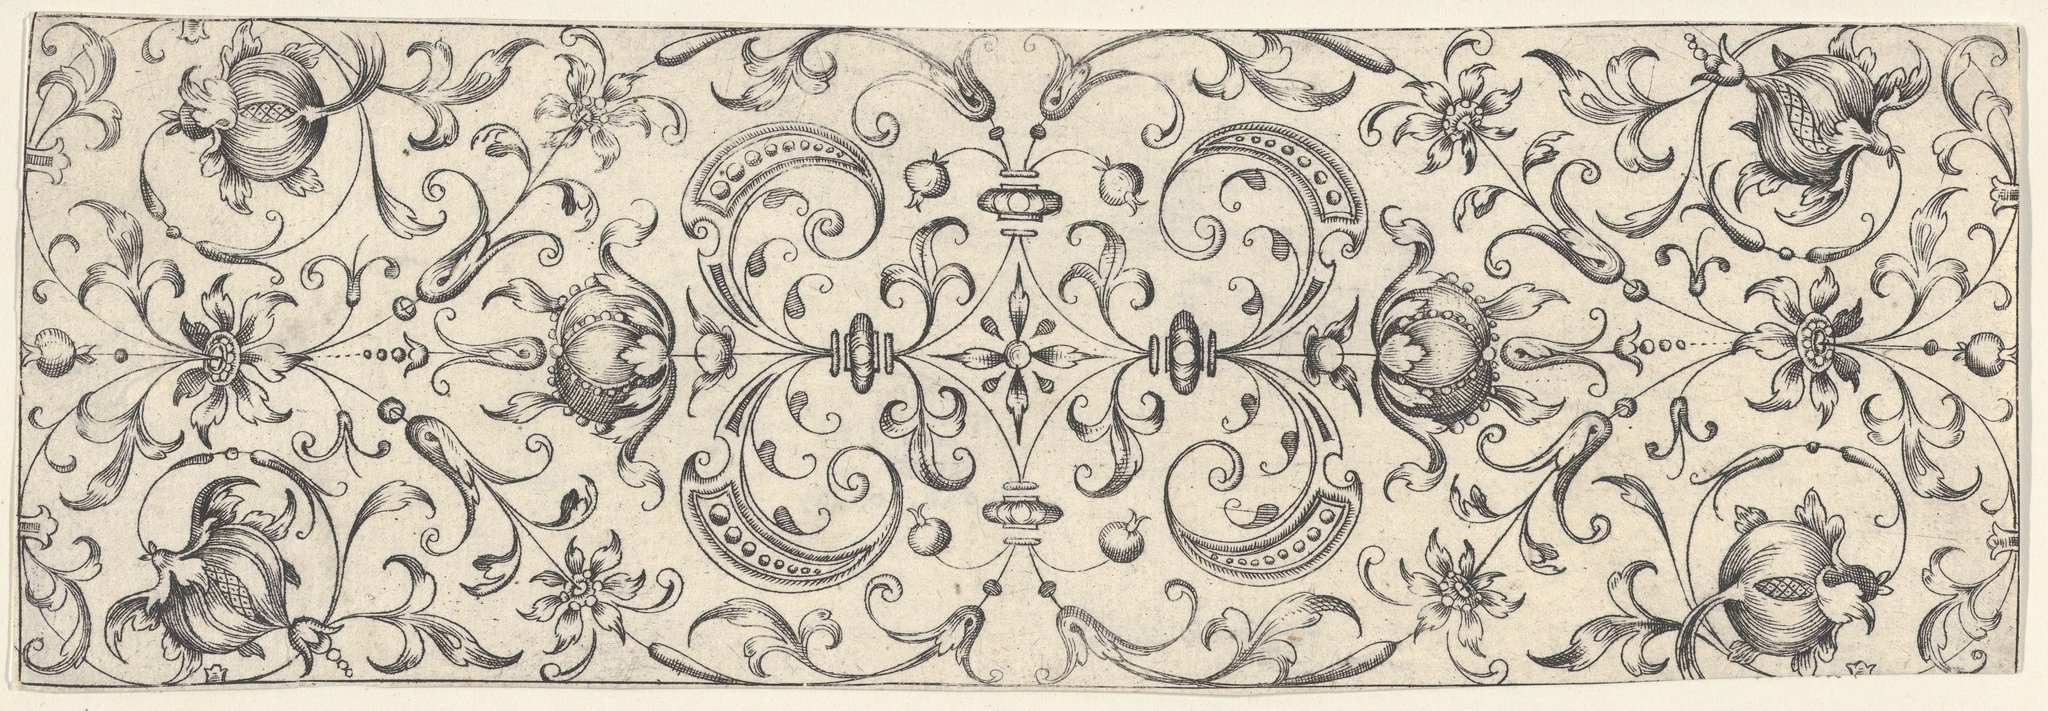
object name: ornament architecture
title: Plate 2, from "Friezes with Birds, Flowers and Meandering Wreaths and Scrolls"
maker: theodor bang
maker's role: artist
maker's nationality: german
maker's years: 1606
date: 1600-1617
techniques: etching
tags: ornament